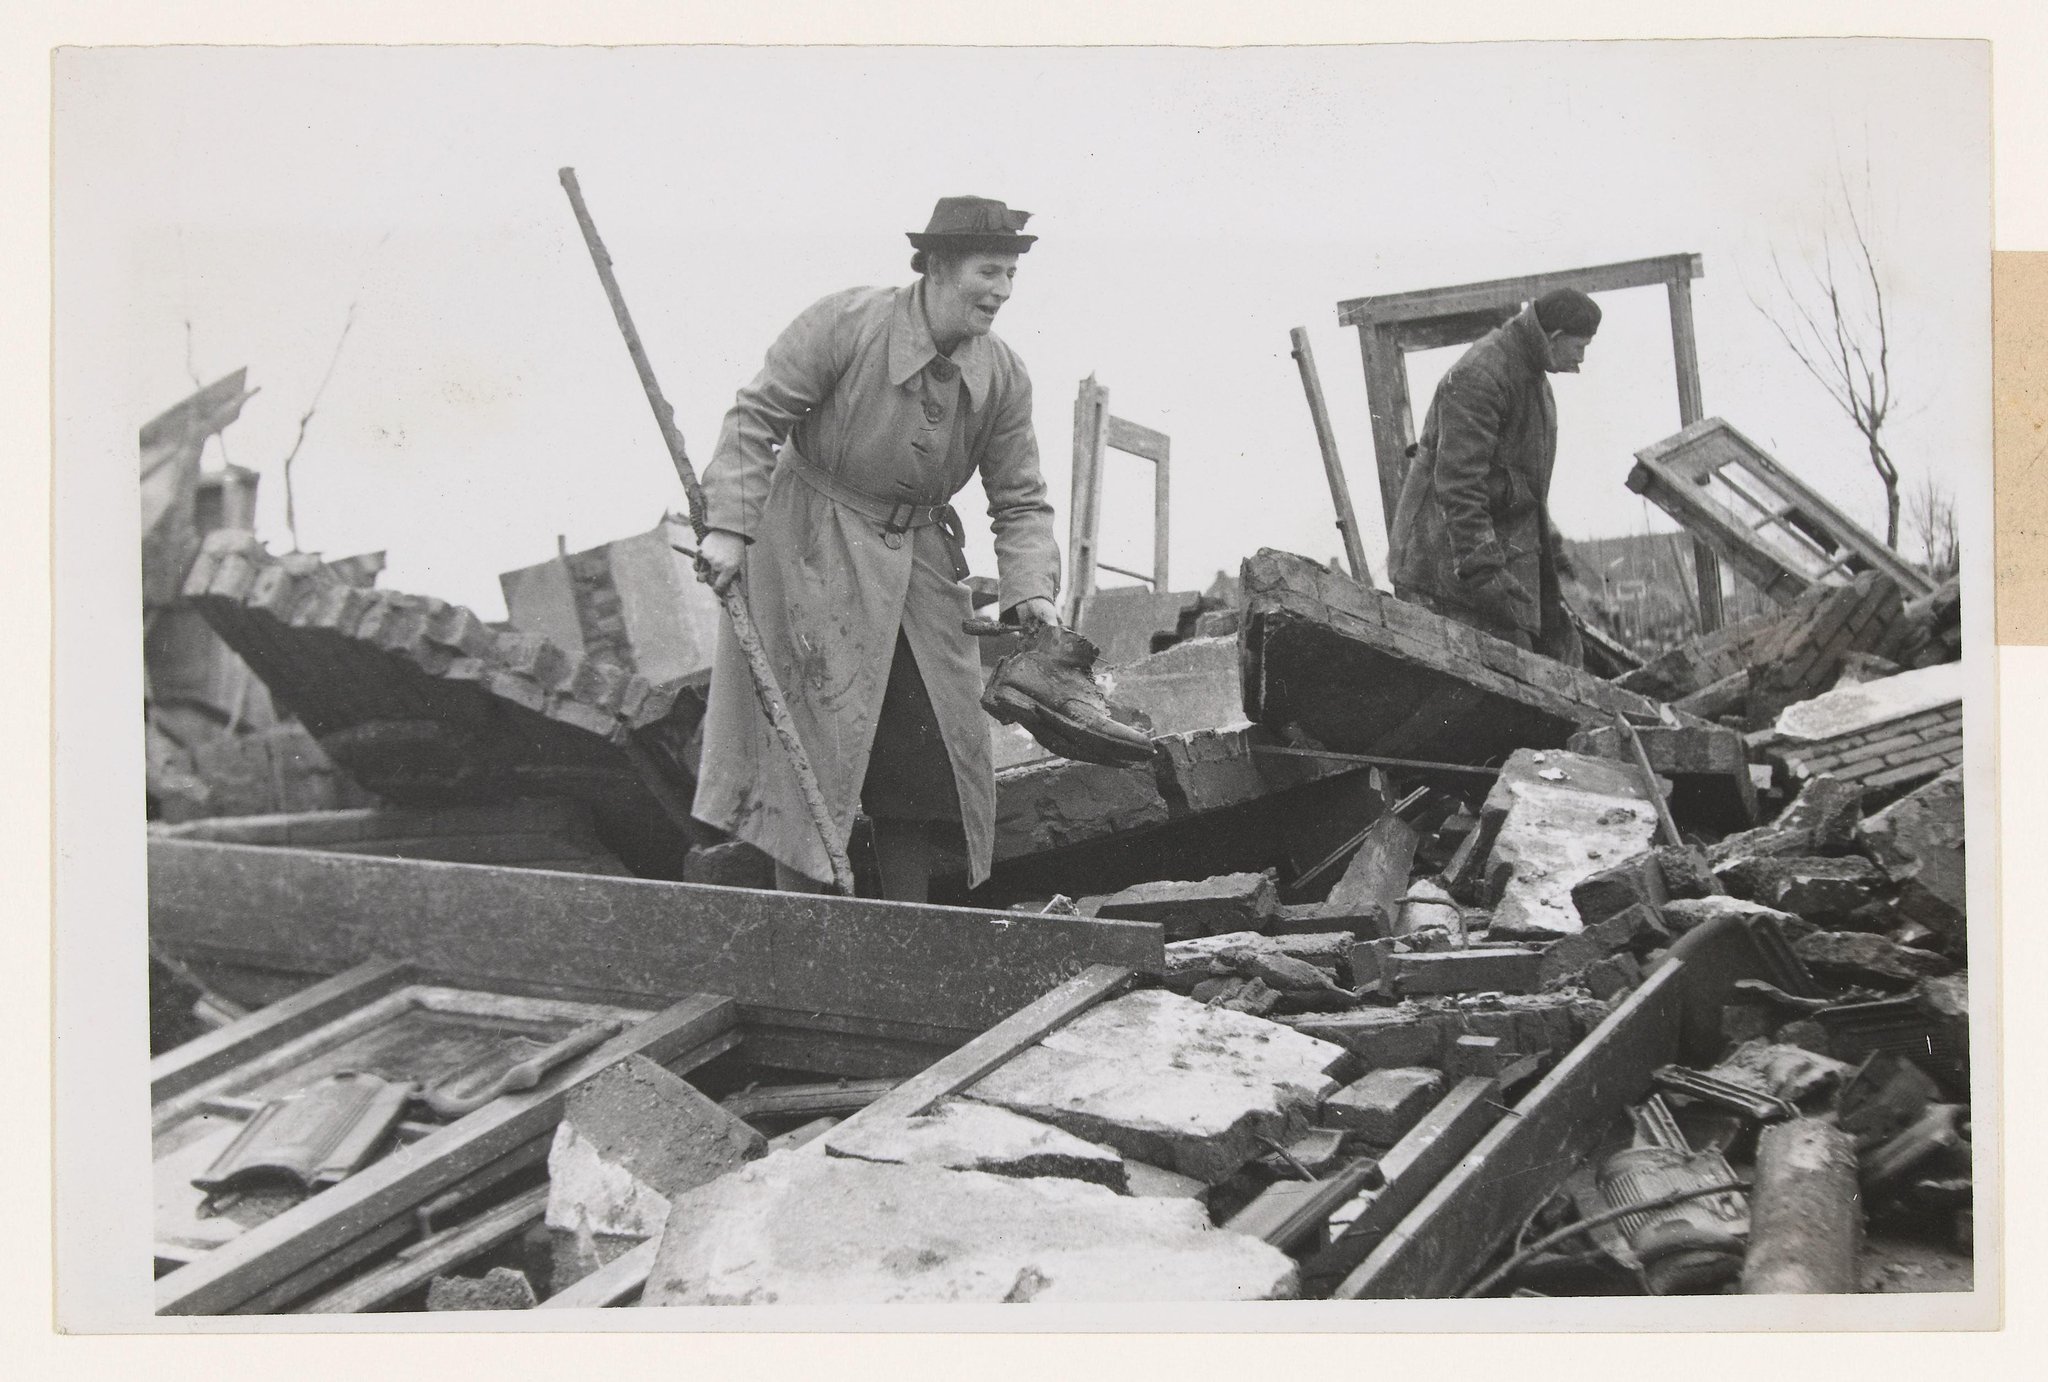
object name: documentary photograph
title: Voormalig bewoonster zoekt naar bruikbare eigendommen in haar oude, volledig verwoeste huis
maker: charles breijer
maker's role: fotograaf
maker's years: 1914-2011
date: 1948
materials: photographic support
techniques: photography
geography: wieringermeer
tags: wieringermeer, tweede wereldoorlog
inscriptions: number: ‘12223’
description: Vrouw met hoed vist uit de puinhopen van haar voormalige boerderij een paar schoenen op.